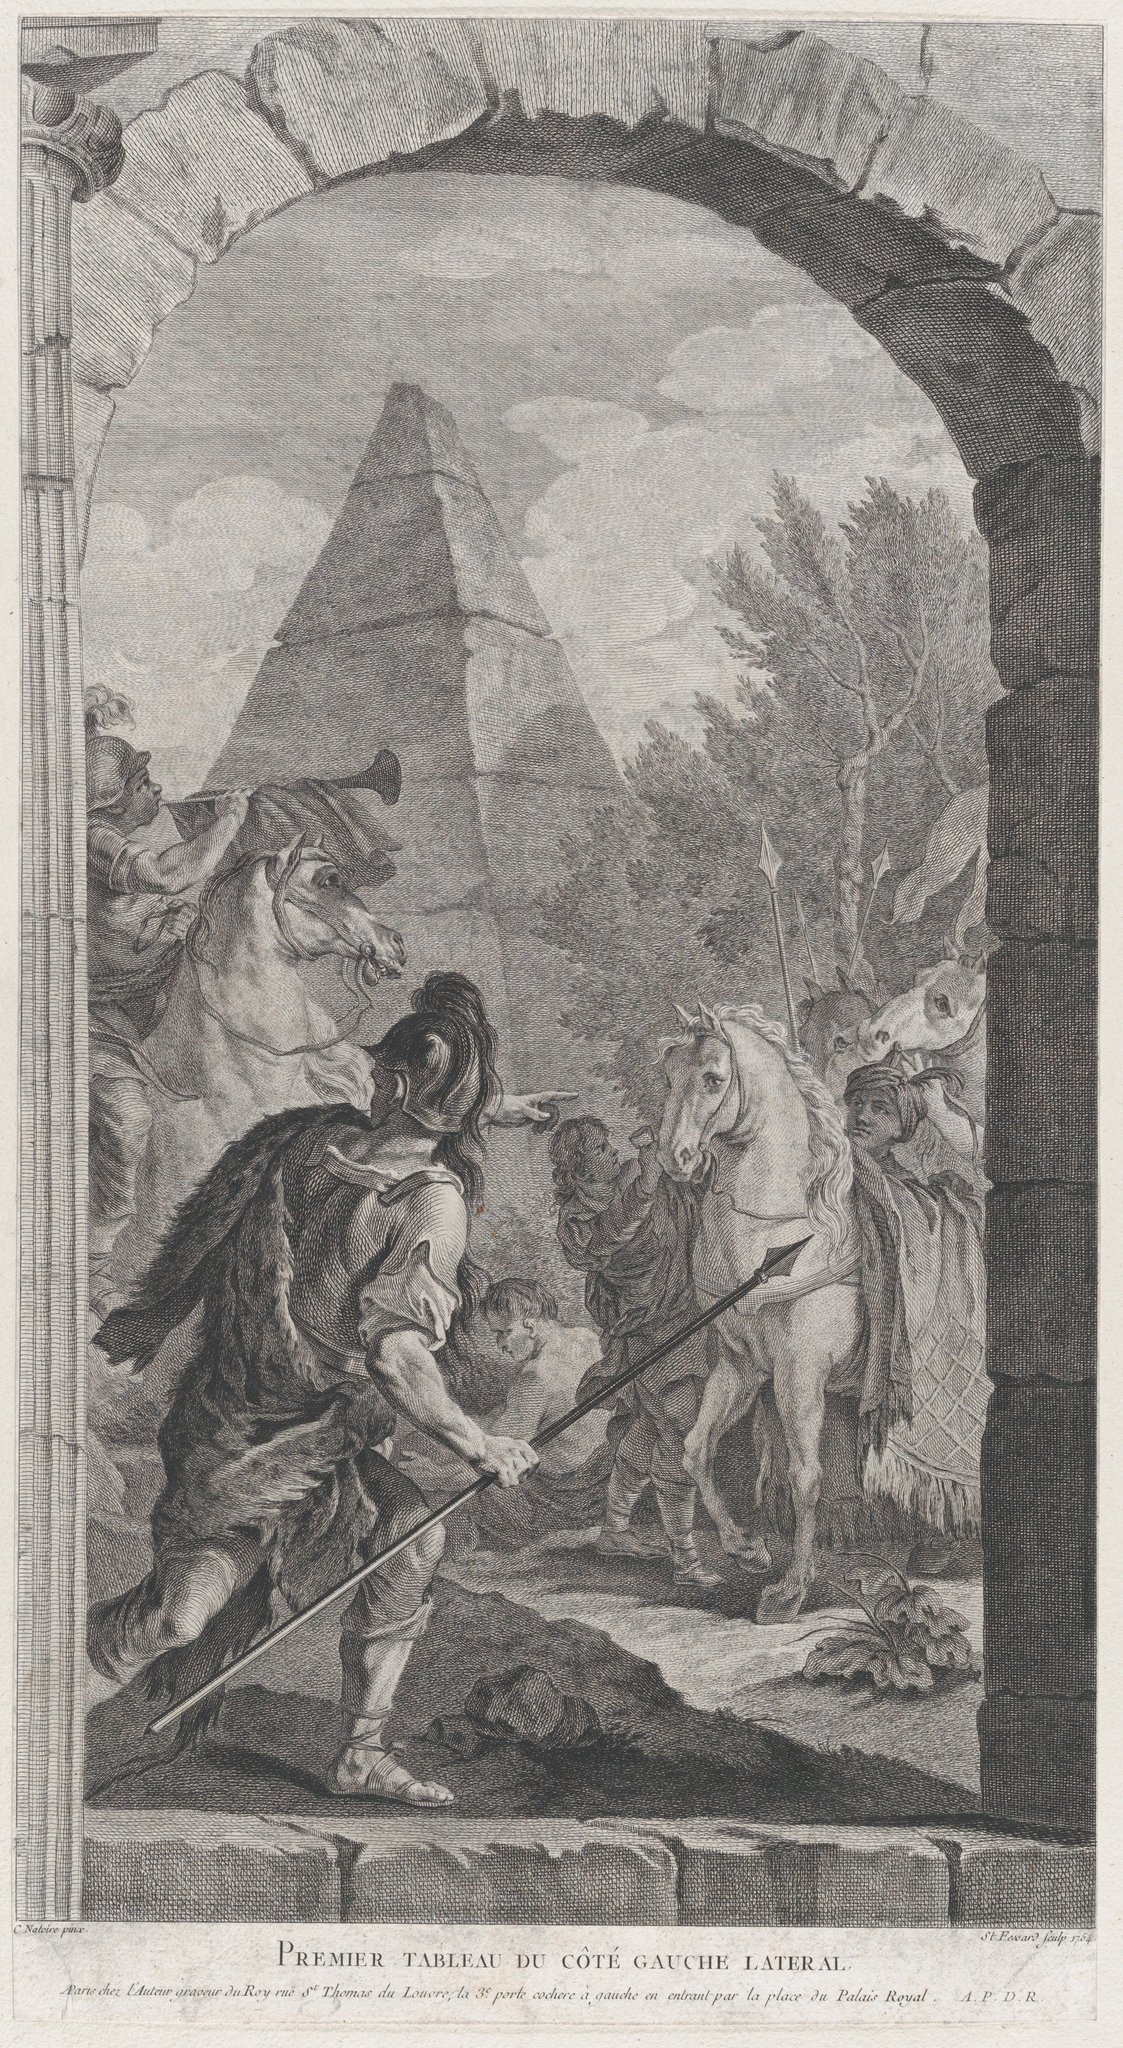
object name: print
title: The Chapel of the Enfants-Trouvés in Paris: La Suite des rois mages: gardes et trompettes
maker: etienne fessard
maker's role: artist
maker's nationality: french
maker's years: 1714-1777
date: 1754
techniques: engraving, etching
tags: soldiers,spears,men,trumpets,horses